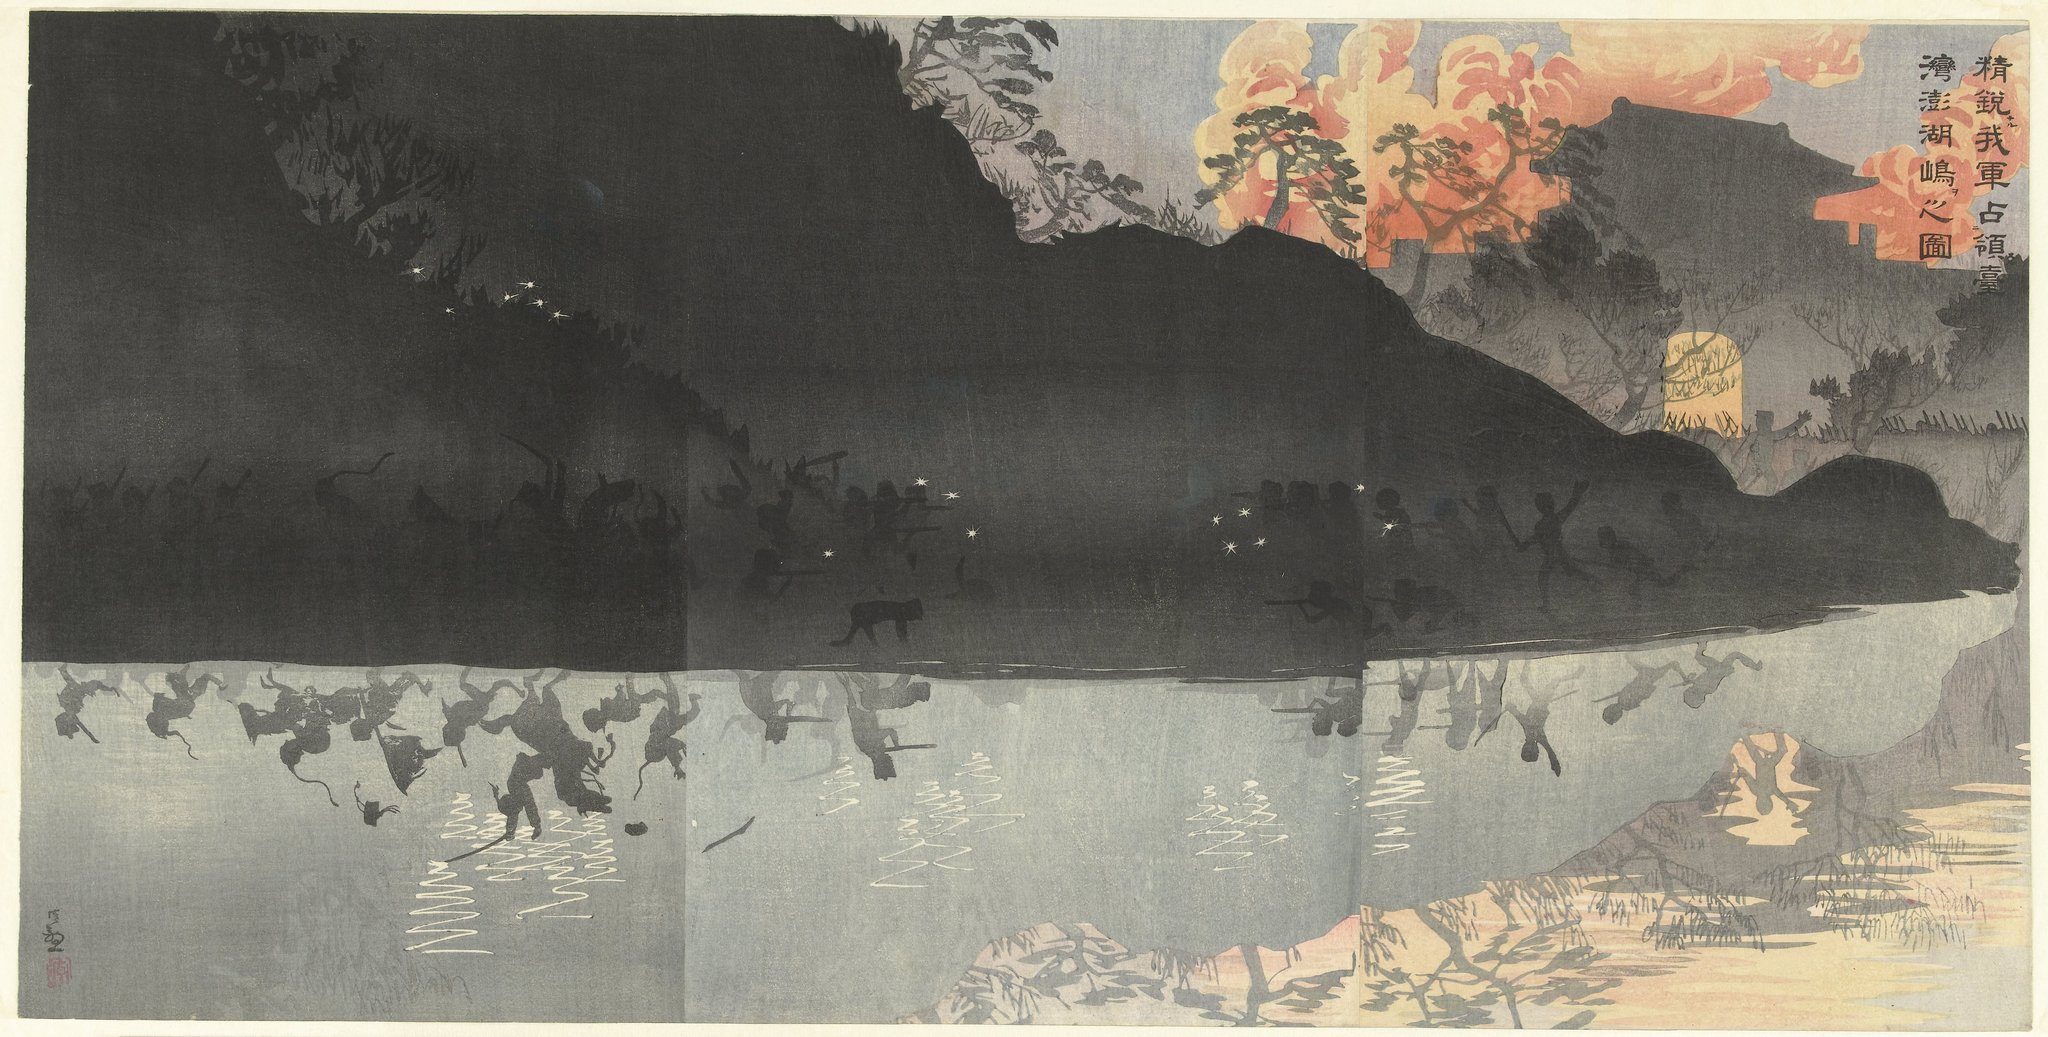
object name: print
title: Onze elite troepen bezetten de Penghu-eilanden bij Taiwan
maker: kobayashi kiyochika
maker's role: print maker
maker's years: 1847-1915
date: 1894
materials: paper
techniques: woodcut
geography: japan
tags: war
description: Gevecht onderaan bergen tussen Japannsers (rechts) en de inheemse bevolking (links), weerspiegeld in het water; op de achtergrond brandende gebouwen.